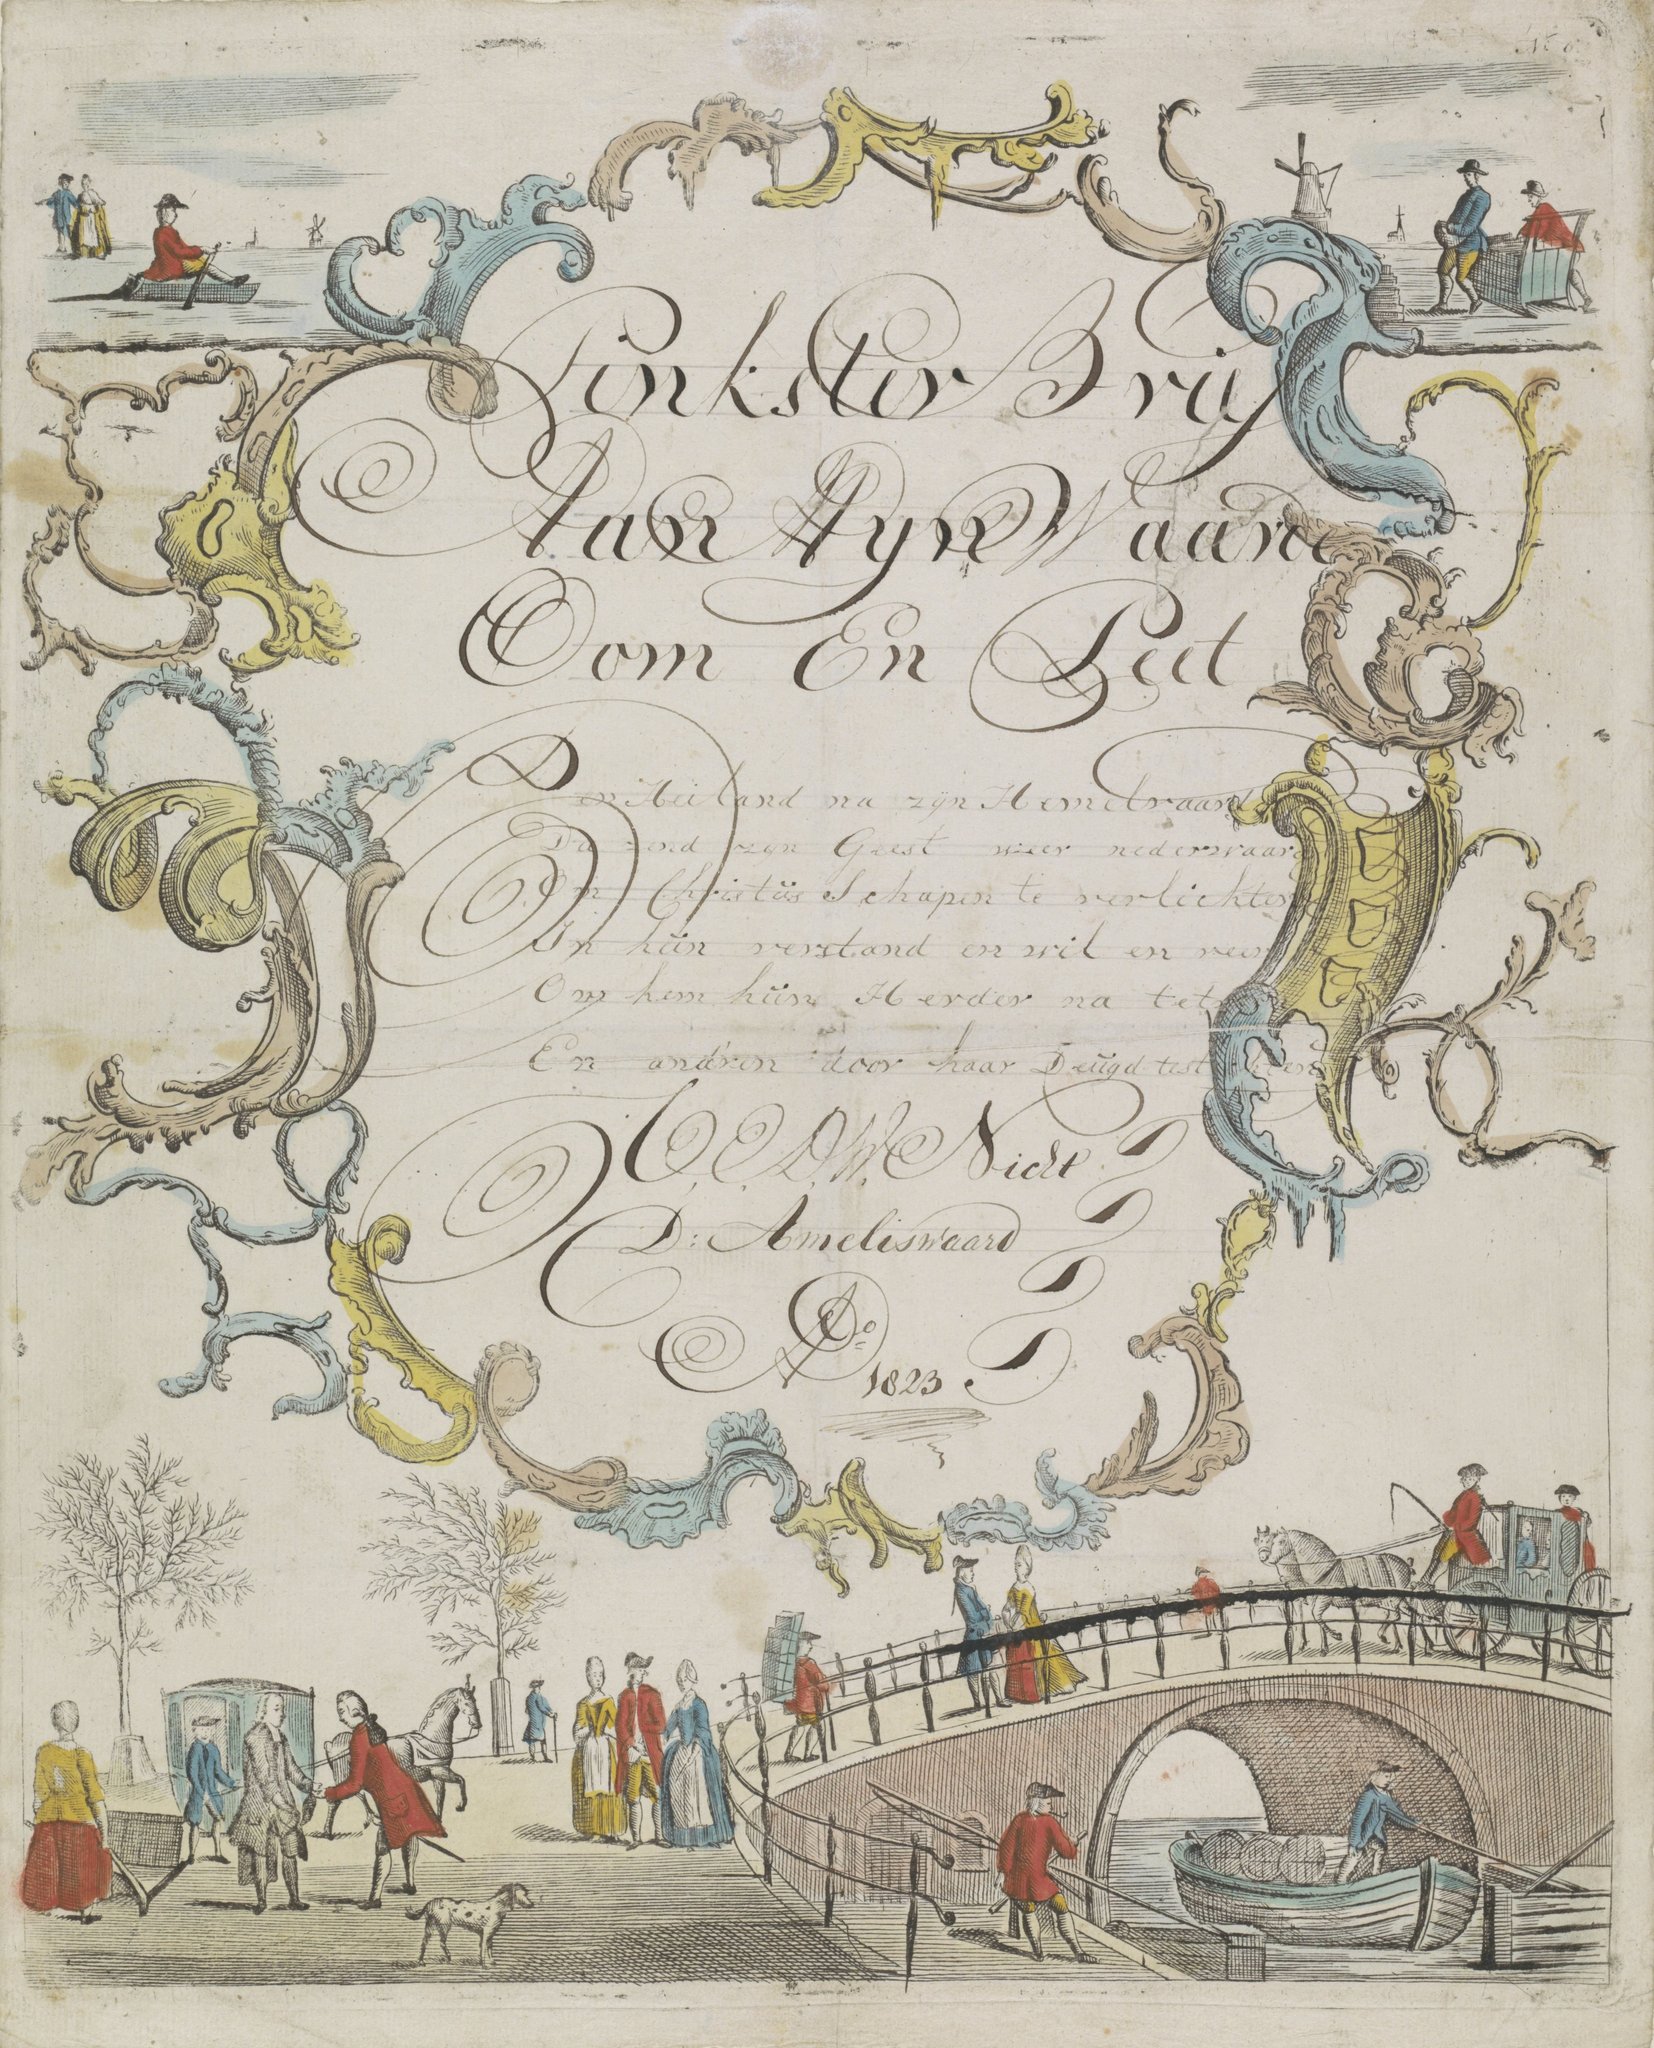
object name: print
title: Wensbrief met Bijbelse taferelen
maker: Anonymous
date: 1823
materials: ink, paper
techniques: calligraphy, colour, etching, pen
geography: netherlands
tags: canal, sleigh, sledge (non-sport), bridge in city across river, canal, etc.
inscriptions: collector's mark: Lugt 2760, inscription: ‘Pinkster brief aan mijn waarde oom en peet / Den heiland na zijn hemelvaard [...]’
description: Wensbrief met beschreven cartouche binnen een decoratief kader met voorstellingen van een brug over een gracht en van een jongen op een slee. Handgeschreven bericht in kalligrafie (Pinksterbrief) door D. Ameliswaard aan oom en tante.